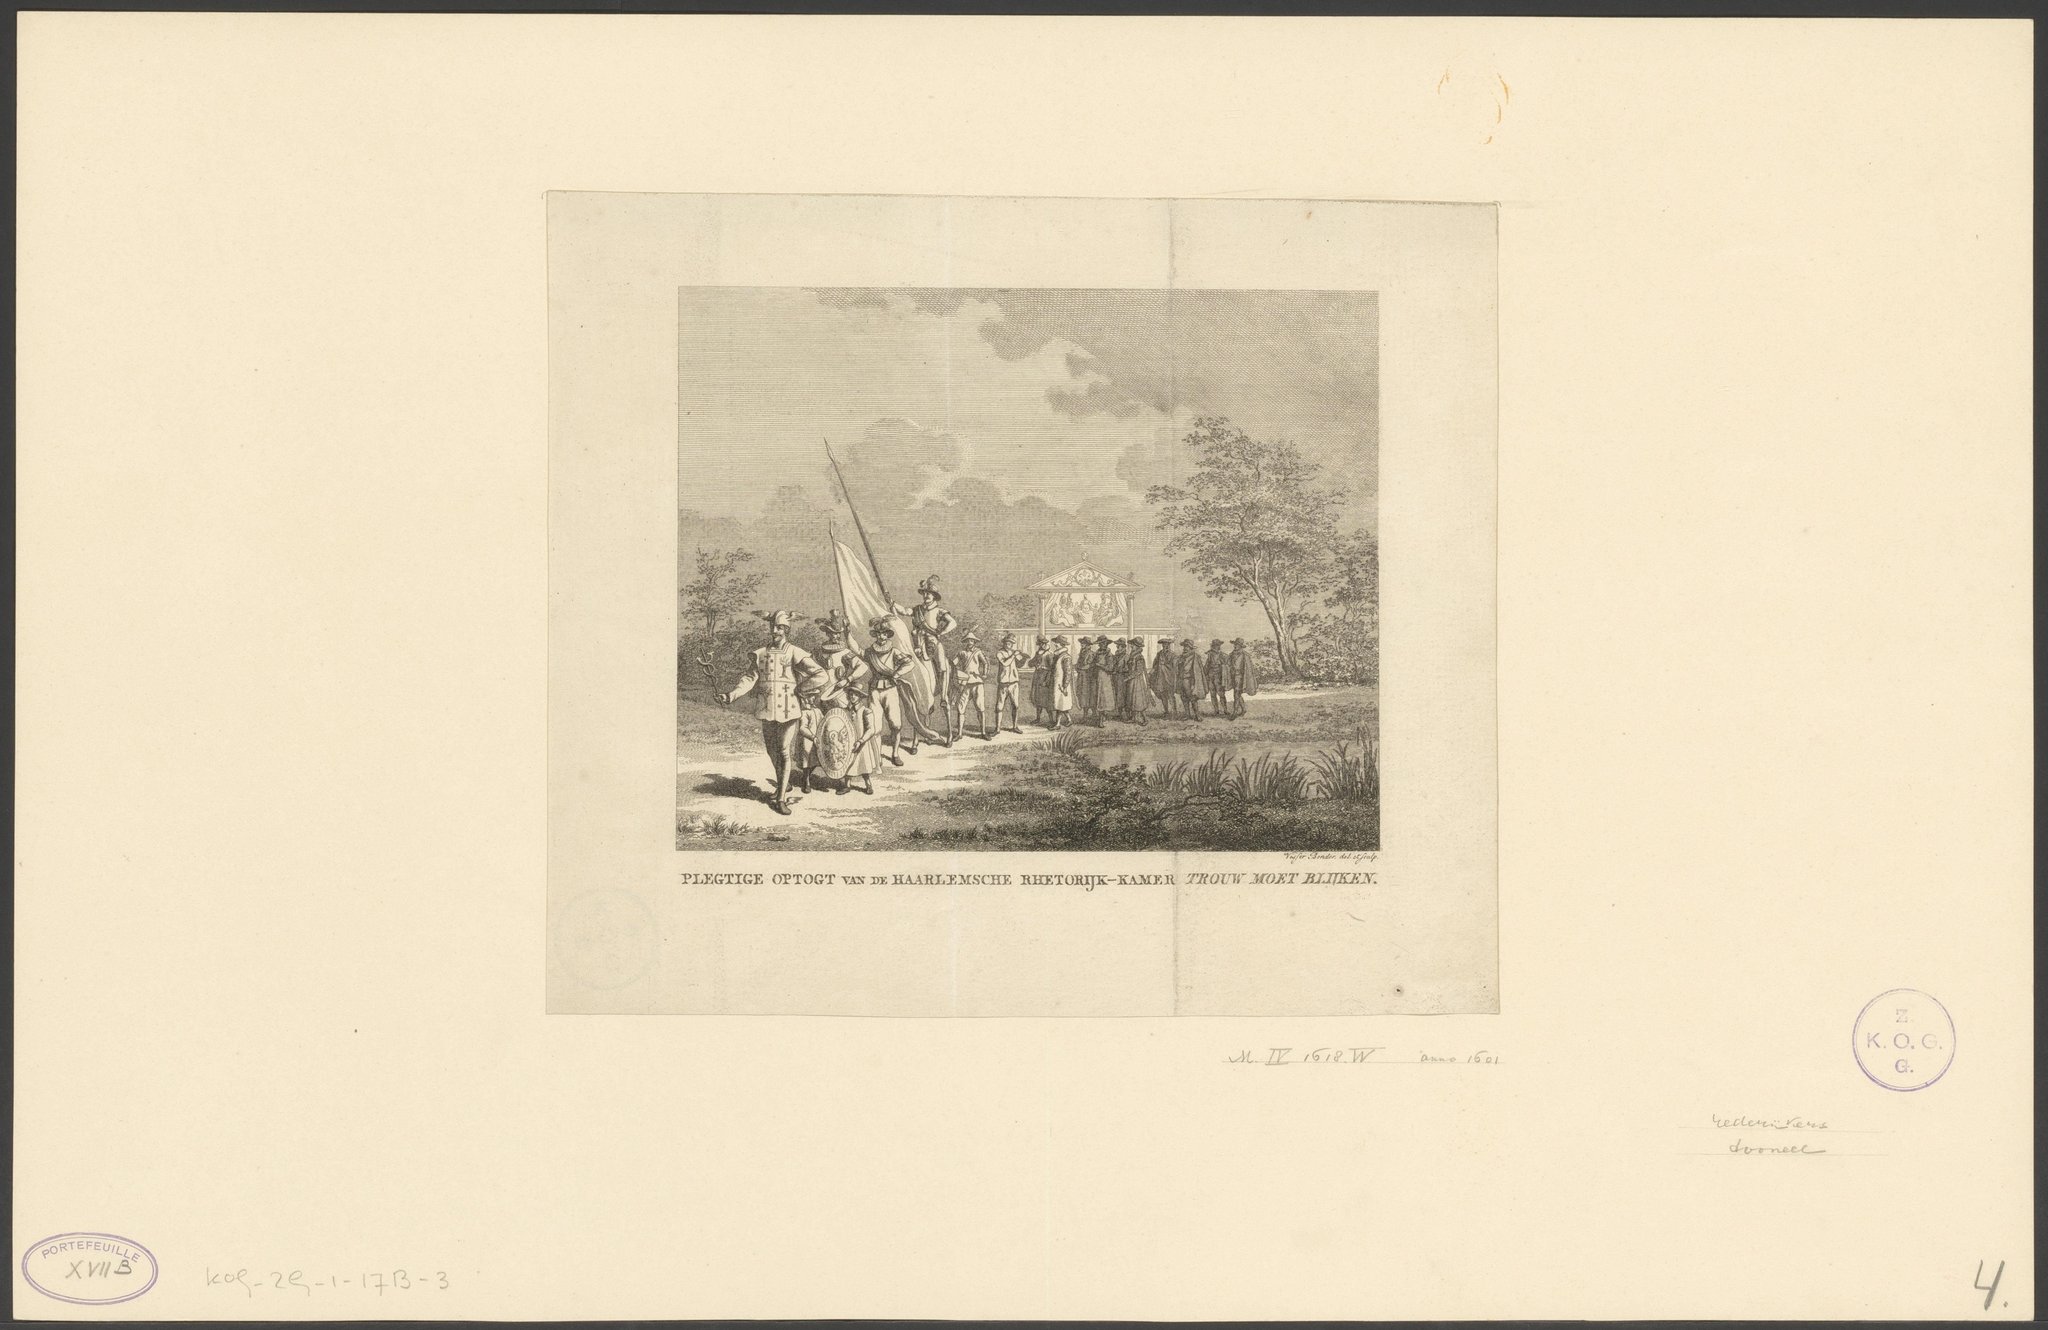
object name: print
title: Optocht van de Haarlemse rederijkerskamer Trou Moet Blycken, 1601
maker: joannes pieter visser bender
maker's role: draughtsman, print maker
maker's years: 1785-1813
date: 1620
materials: paper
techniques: engraving, etching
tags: pageant of a guild, 'rhetorica', 'eloquentia' (~ trivium); 'rettorica' (ripa), chamber of rhetoric (dutch: 'rederijkerskamer'), haarlem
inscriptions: stamp: Lugt 1641, collector's mark: Lugt 1641, stamp:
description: Optocht van de leden van de Haarlemse rederijkerskamer De Pellicaen of Trou Moet Blycken, 20 augustus 1601. De stoet wordt voorafgegaan door een man in wapenrok versierd met de wapens van Haarlem, daarachter twee jongens met het blazoen, een prijs gewonnen in Brussel. Onderwerpsrubrieken binnen de Atlas Zeden en Gewoonten: Schoone kunsten, Tooneel, Rederijkers.